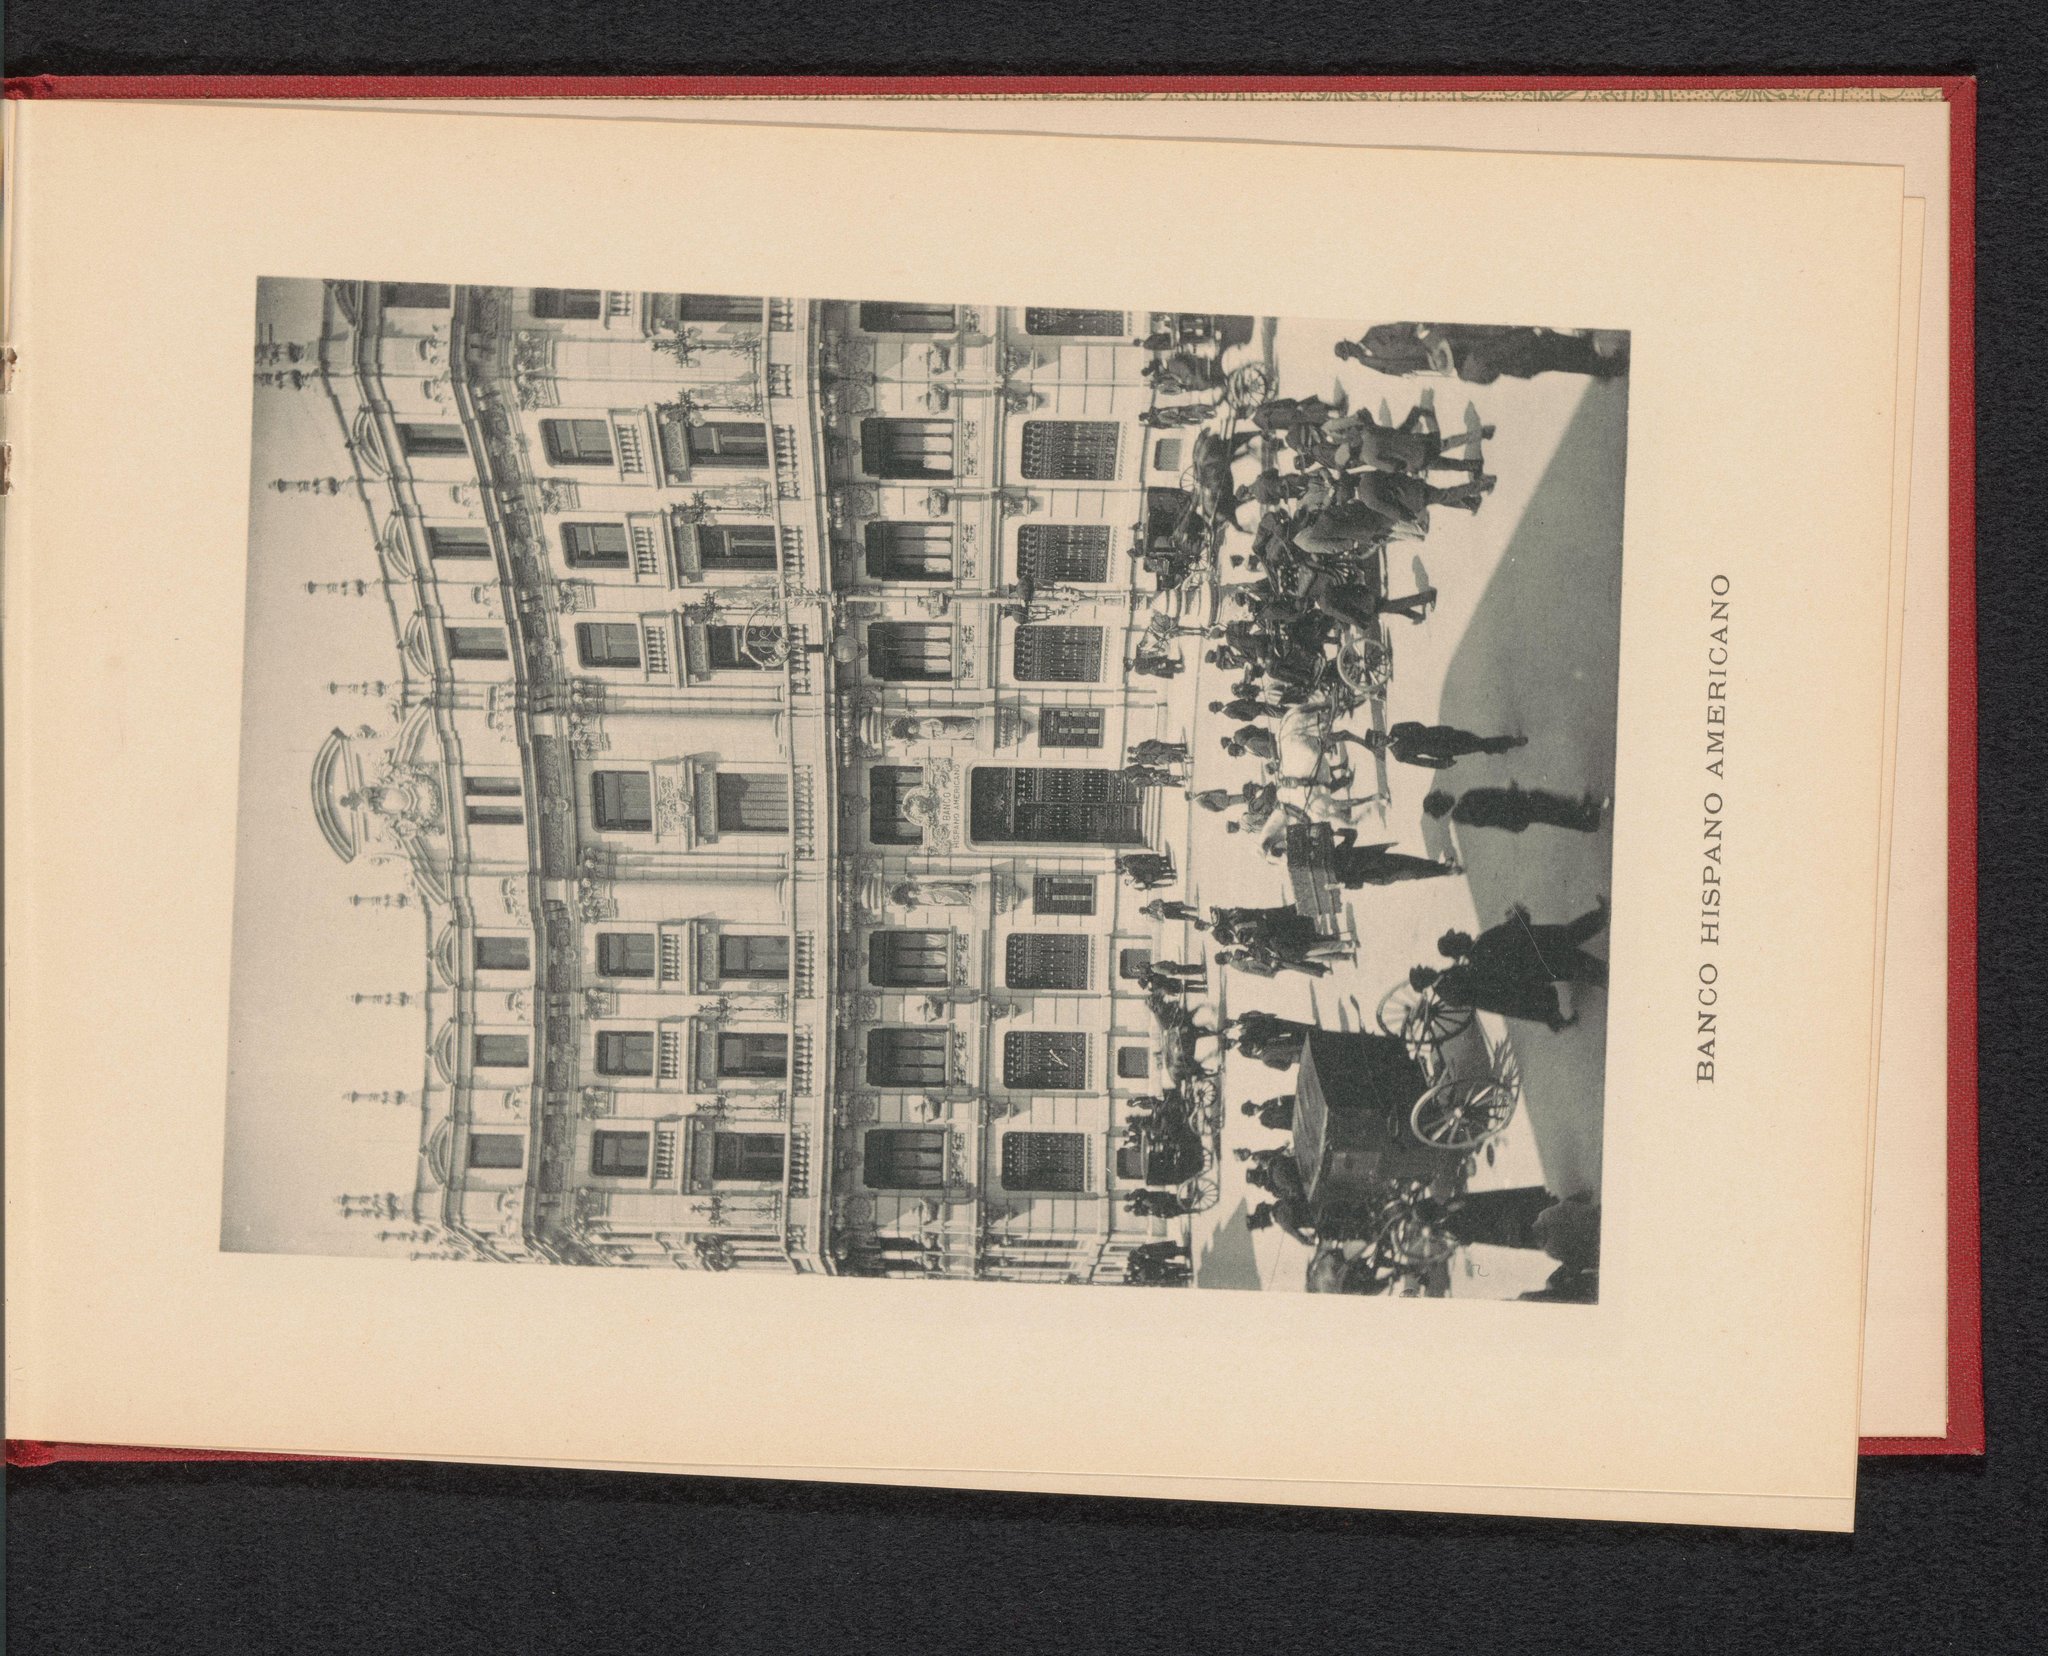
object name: photomechanical print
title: Gezicht op het gebouw van de Banco Hispano Americano in Madrid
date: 1888-1898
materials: paper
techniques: photograph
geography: madrid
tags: four-wheeled, animal-drawn vehicle, e.g.: cab, carriage, coach, bank